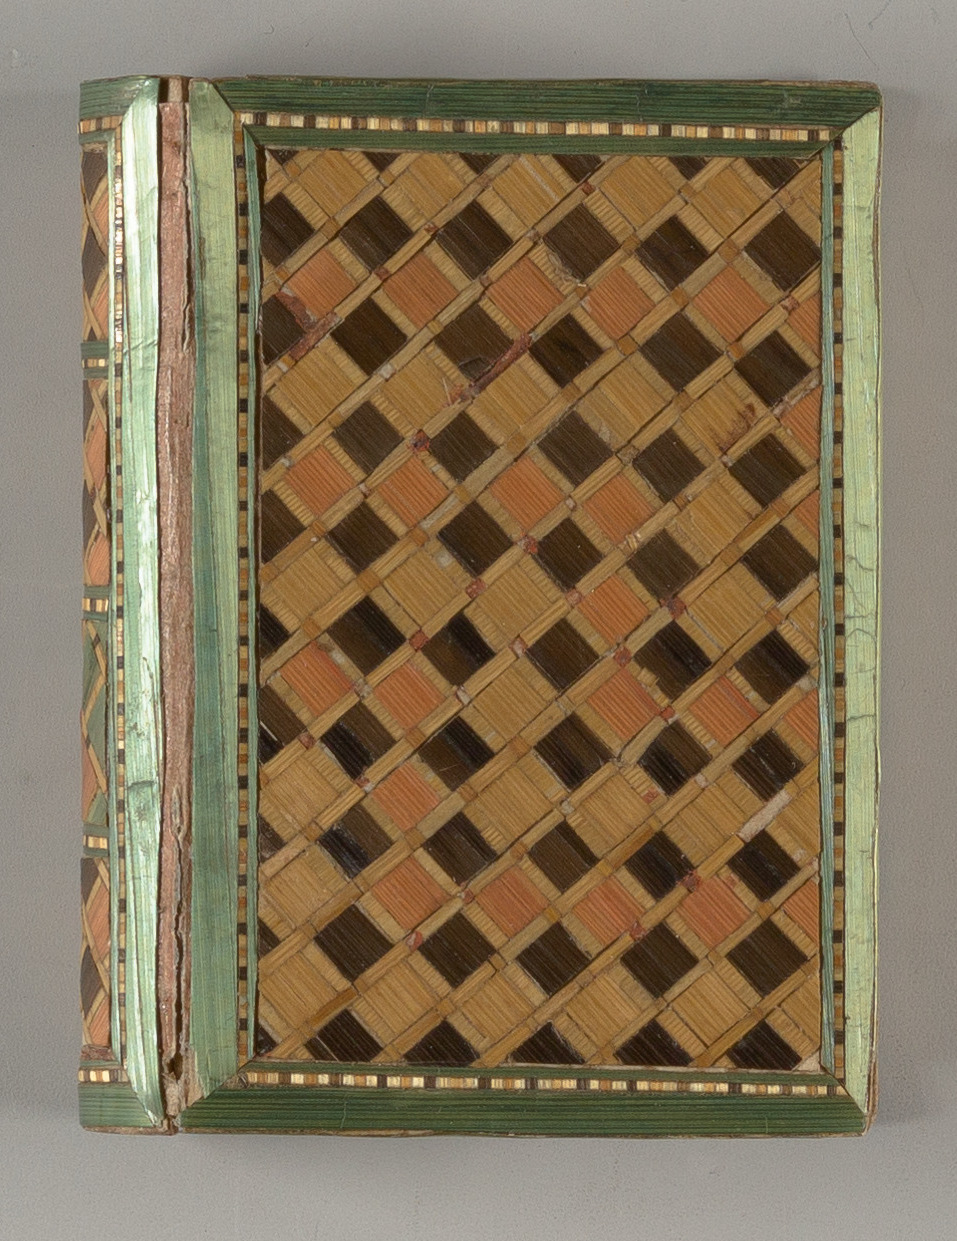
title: Straw-work sewing box in book form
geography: france